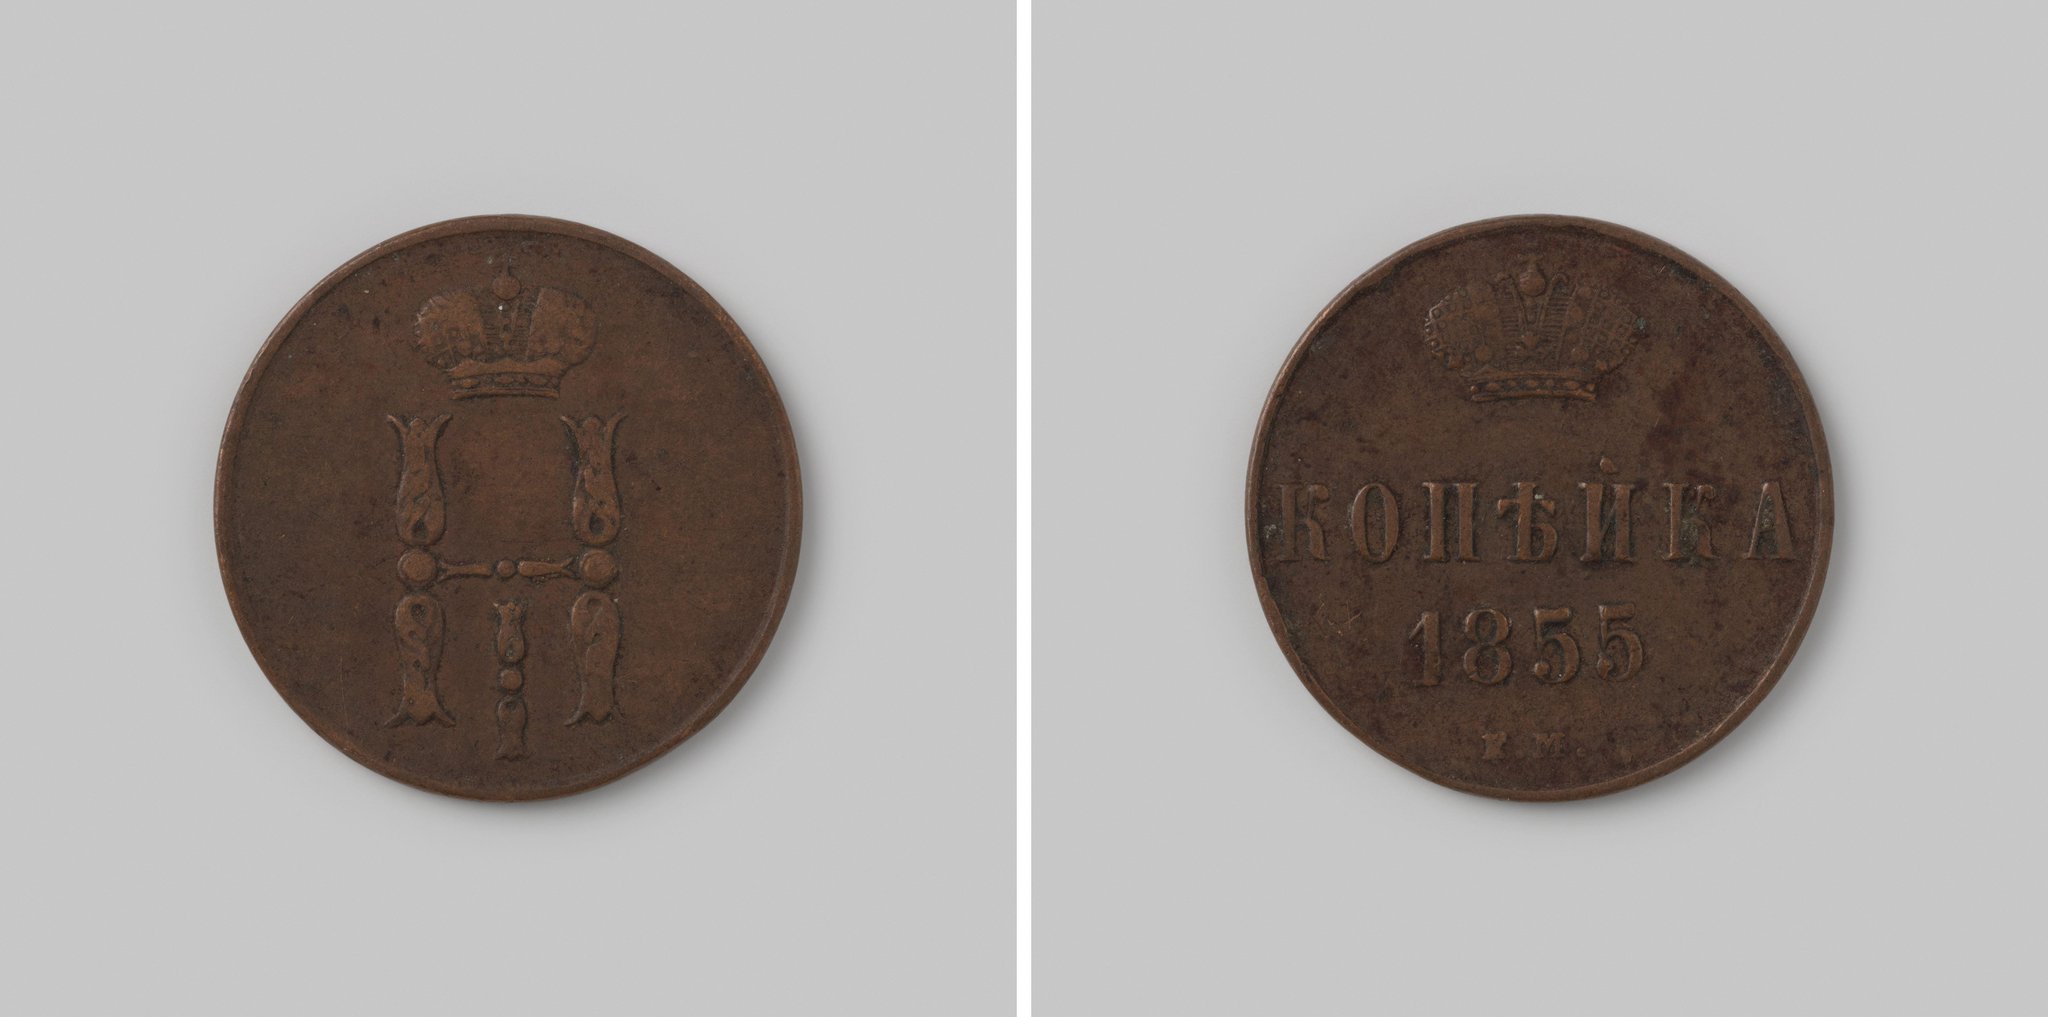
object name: coin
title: Rusland, tsaar Nikolai I, kopek, 1855 EM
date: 1855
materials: copper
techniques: striking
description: Koperen munt. Voorzijde: gekroond monogram van Nicolai I in het cyrillisch. Keerzijde: in een regel waarde-aanduiding. Daaronder jaartal, waaronder in het Cyrillisch de letters E en M [=Ekaterinenburg]. Gladde rand.